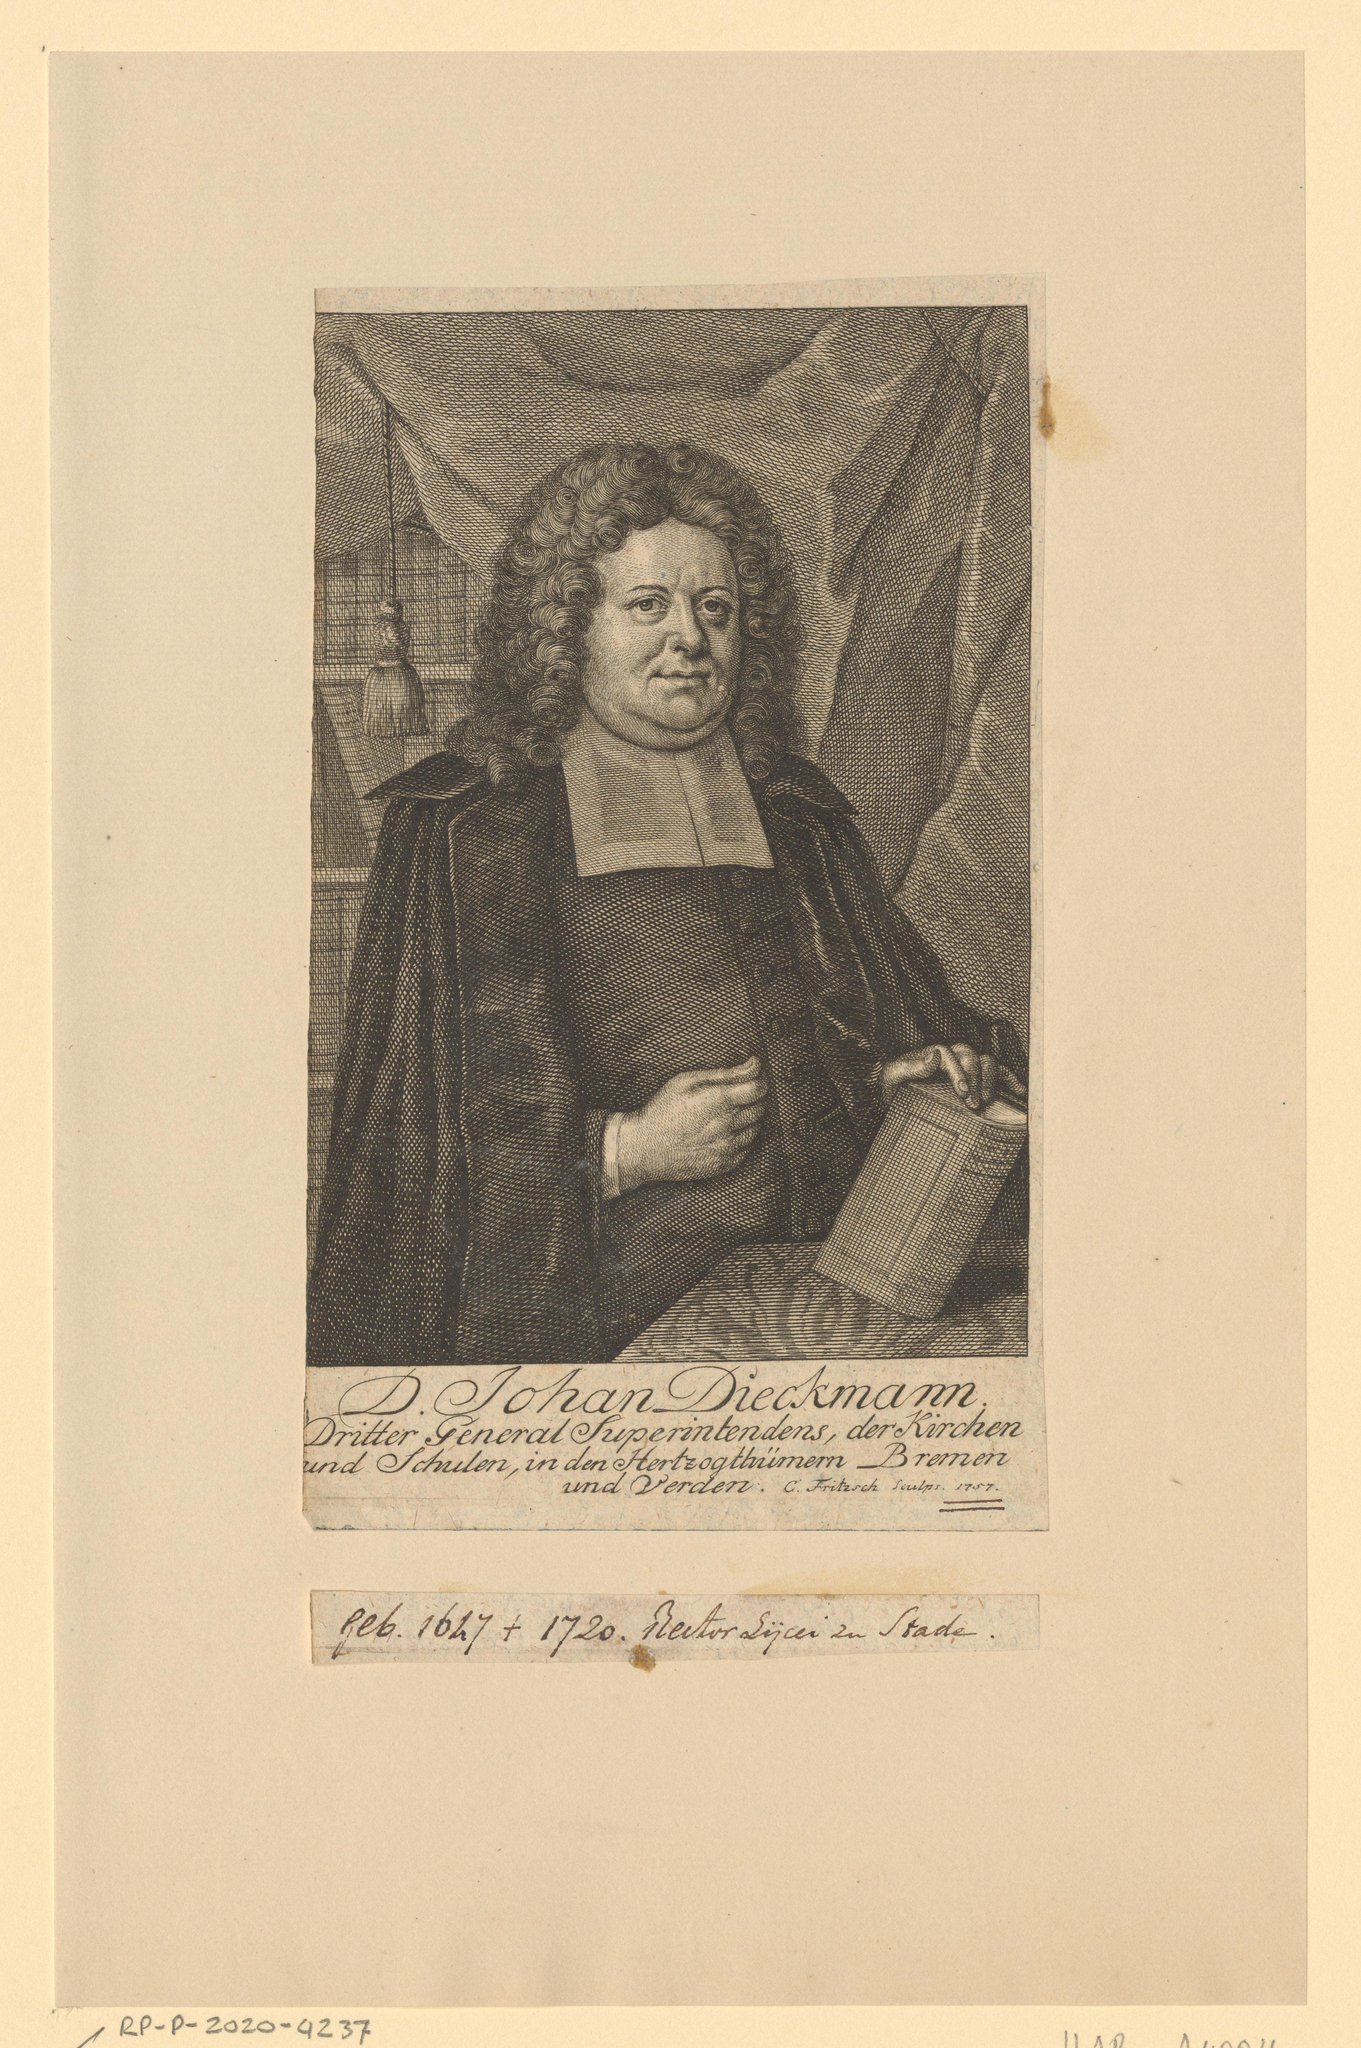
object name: print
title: Portret van Johann Dieckmann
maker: christian fritzsch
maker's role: print maker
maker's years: 1695-1769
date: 1757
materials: paper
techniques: engraving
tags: theologian, historical persons